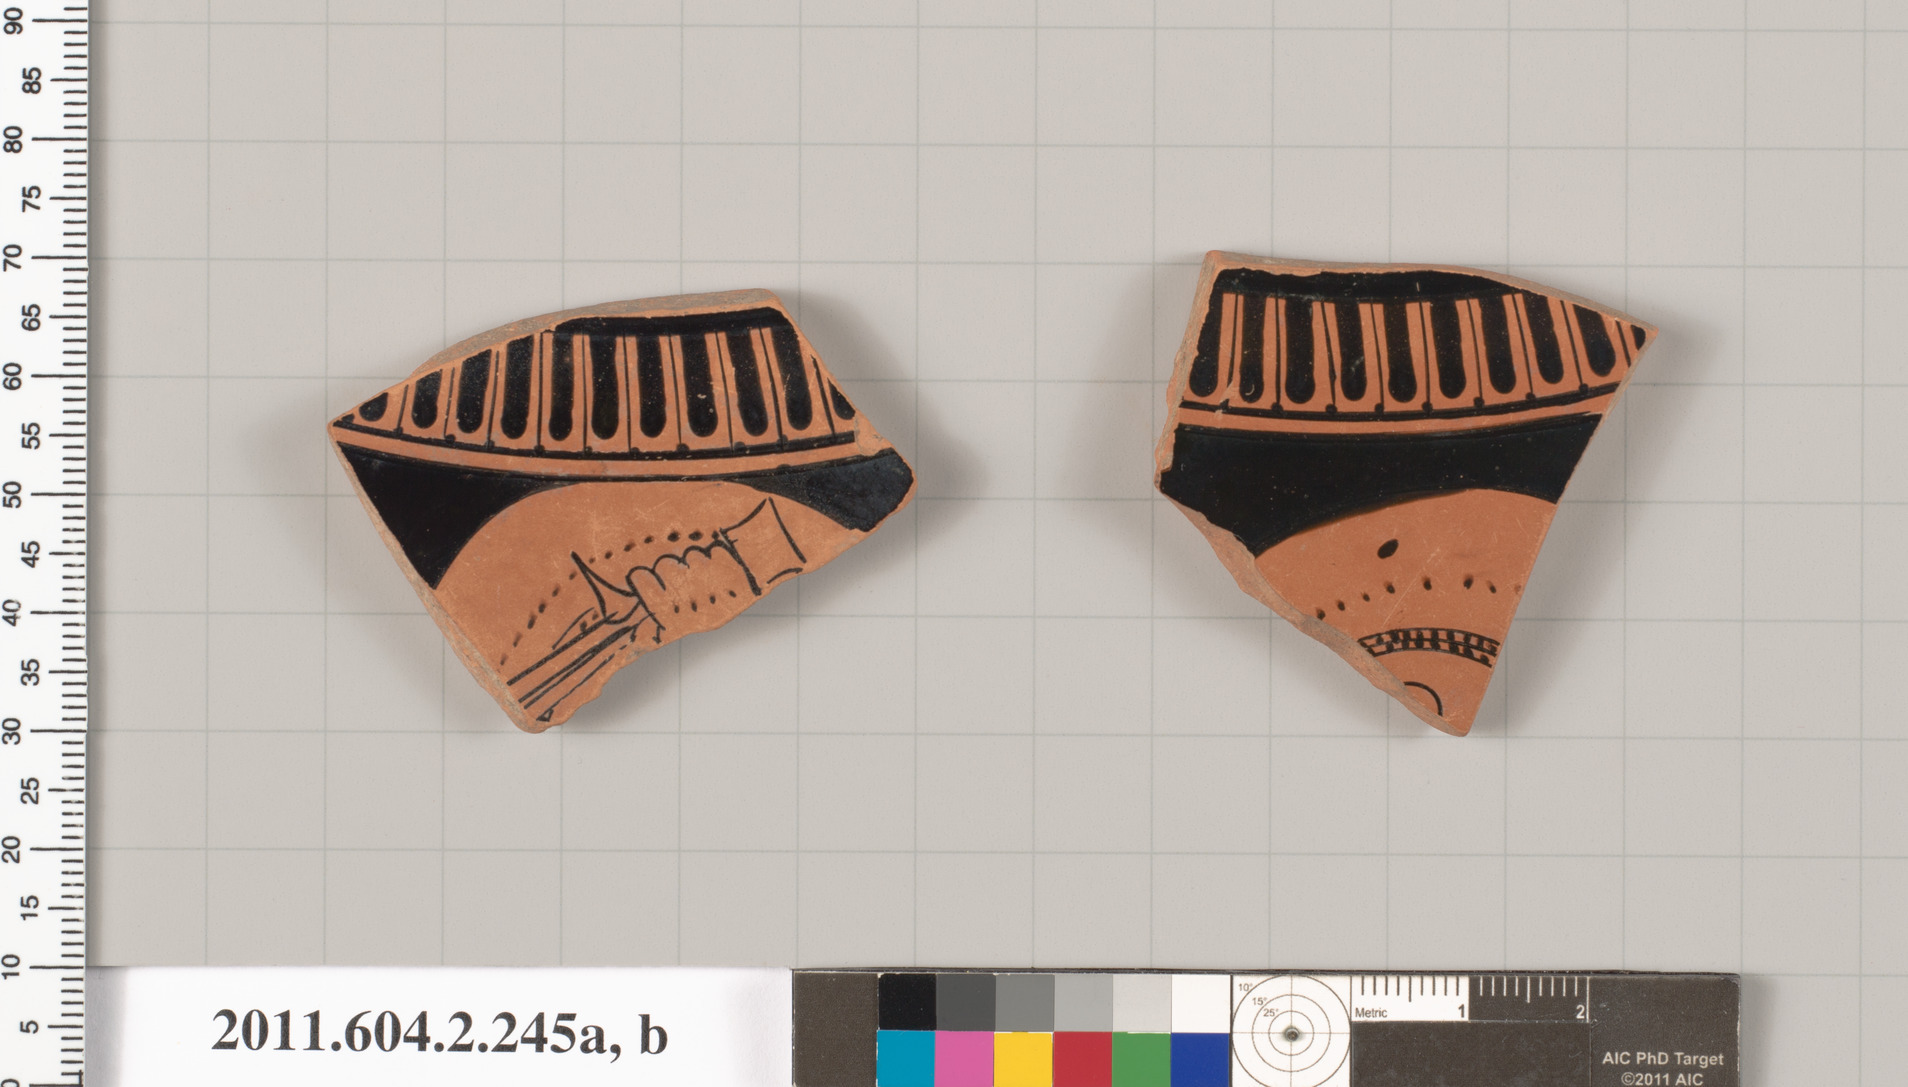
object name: stamnos fragment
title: Terracotta fragments of a stamnos (jar)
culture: greek, attic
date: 490-480 BCE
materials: terracotta